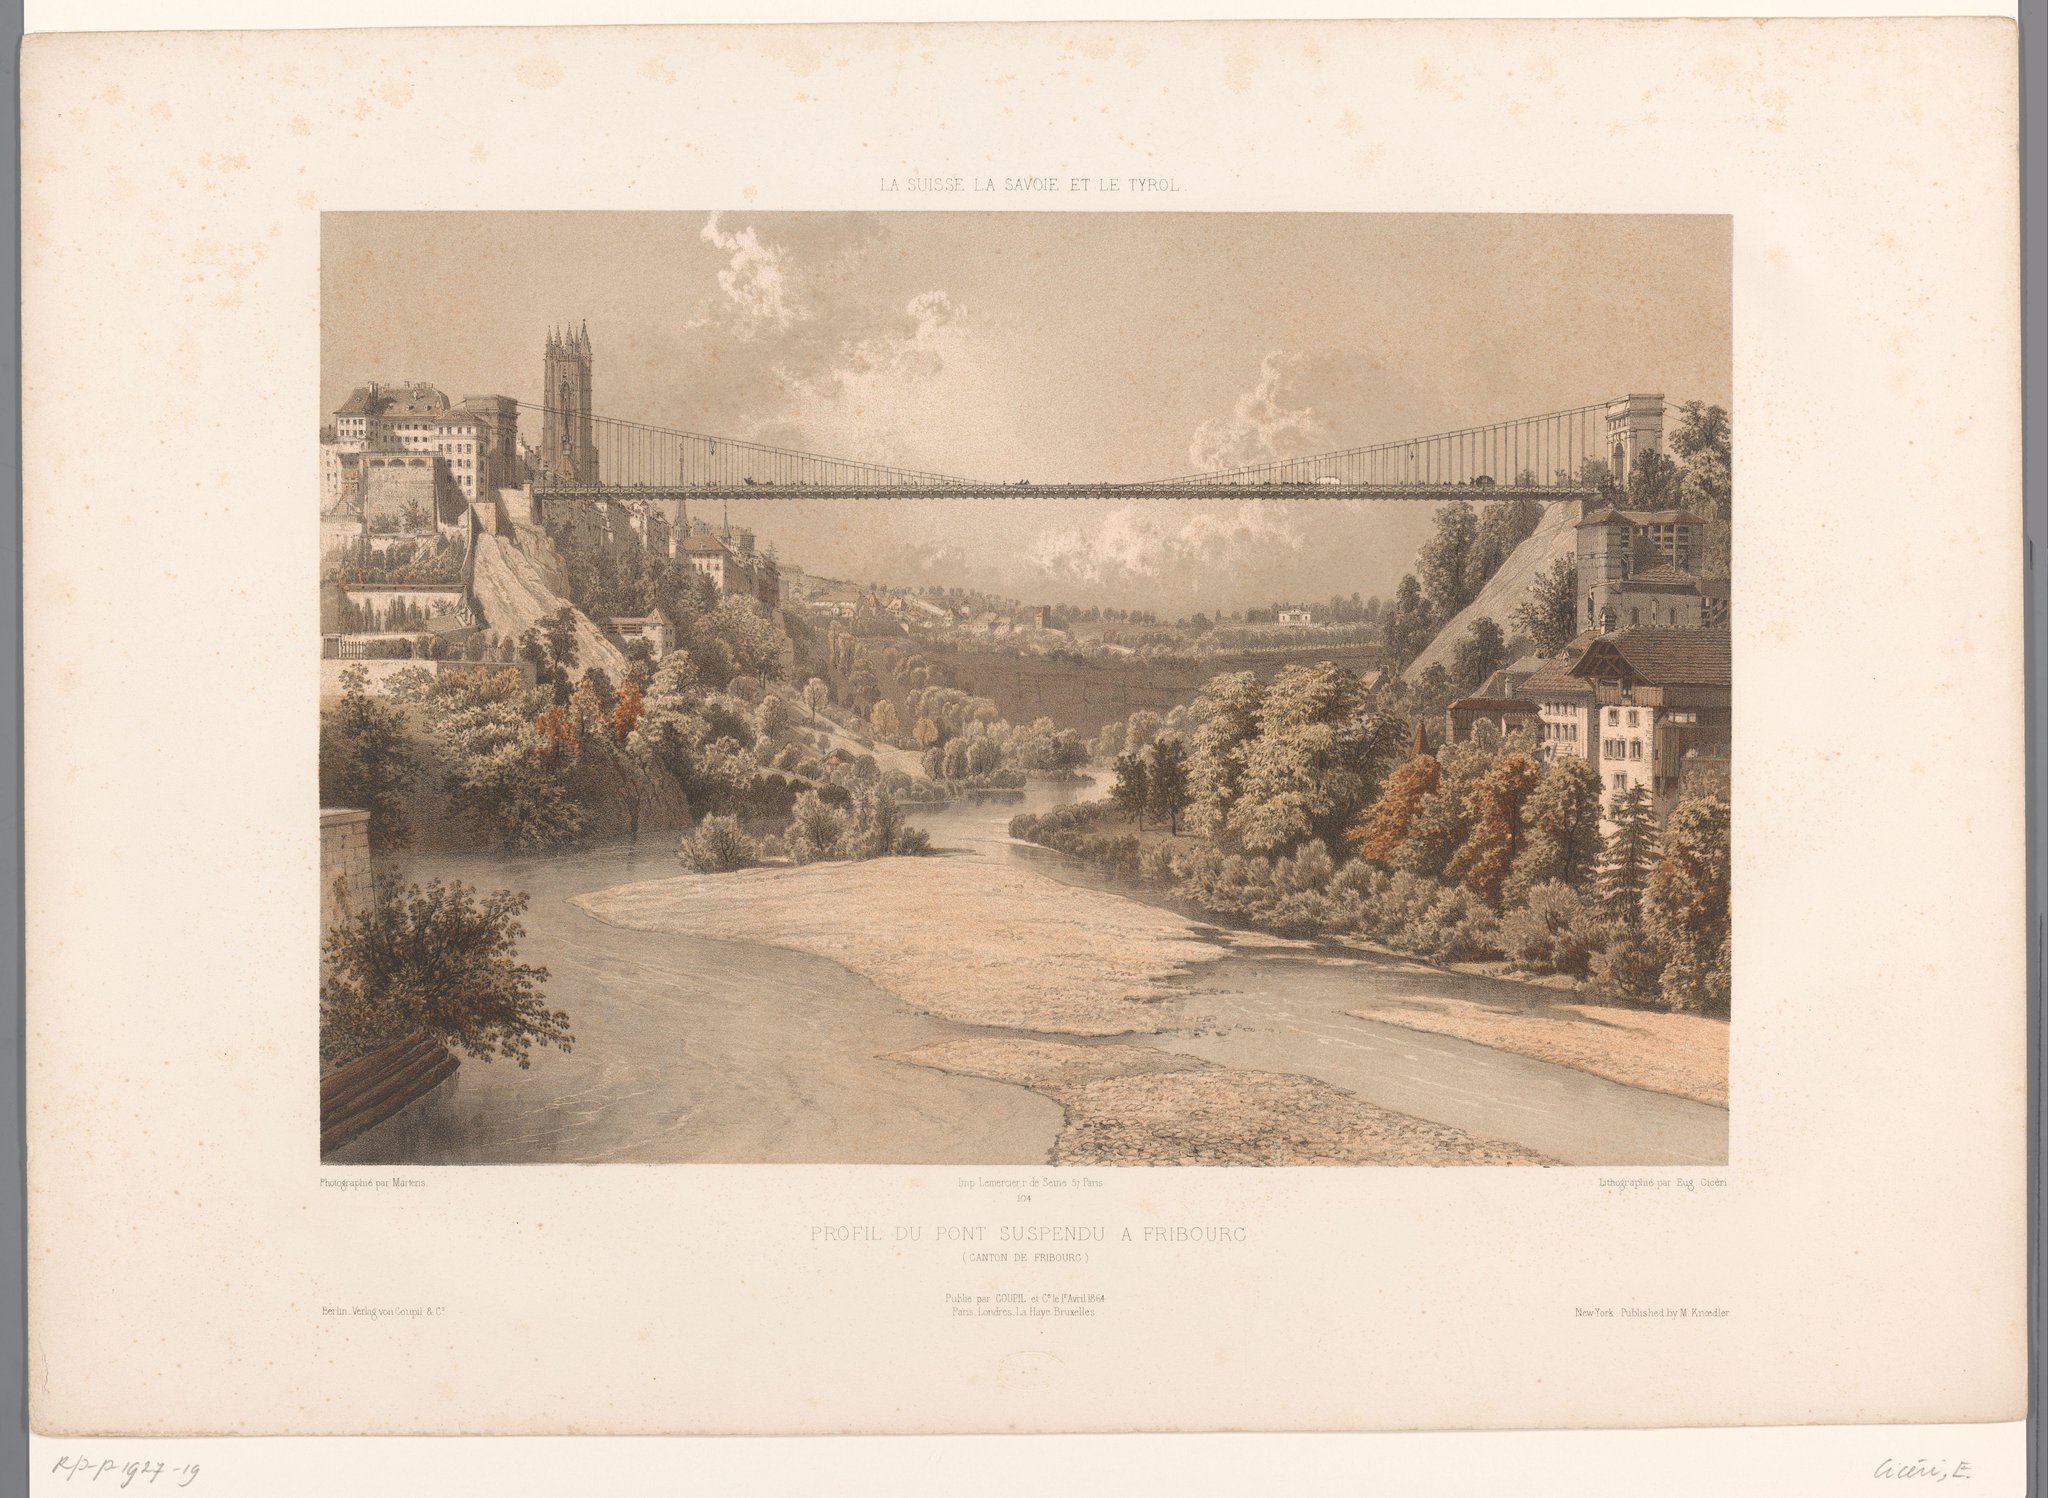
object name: print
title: Profil du pont suspendu à Fribourc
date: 1859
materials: paper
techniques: lithograph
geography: paris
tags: bridge in city across river, canal, etc. (+ city(-scape) with figures, staffage)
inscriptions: check stamp: Lugt 1090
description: De oude hangbrug uit 1834 over de Sarine is in 1923 afgebroken en vervangen door de Zähringen-brug.